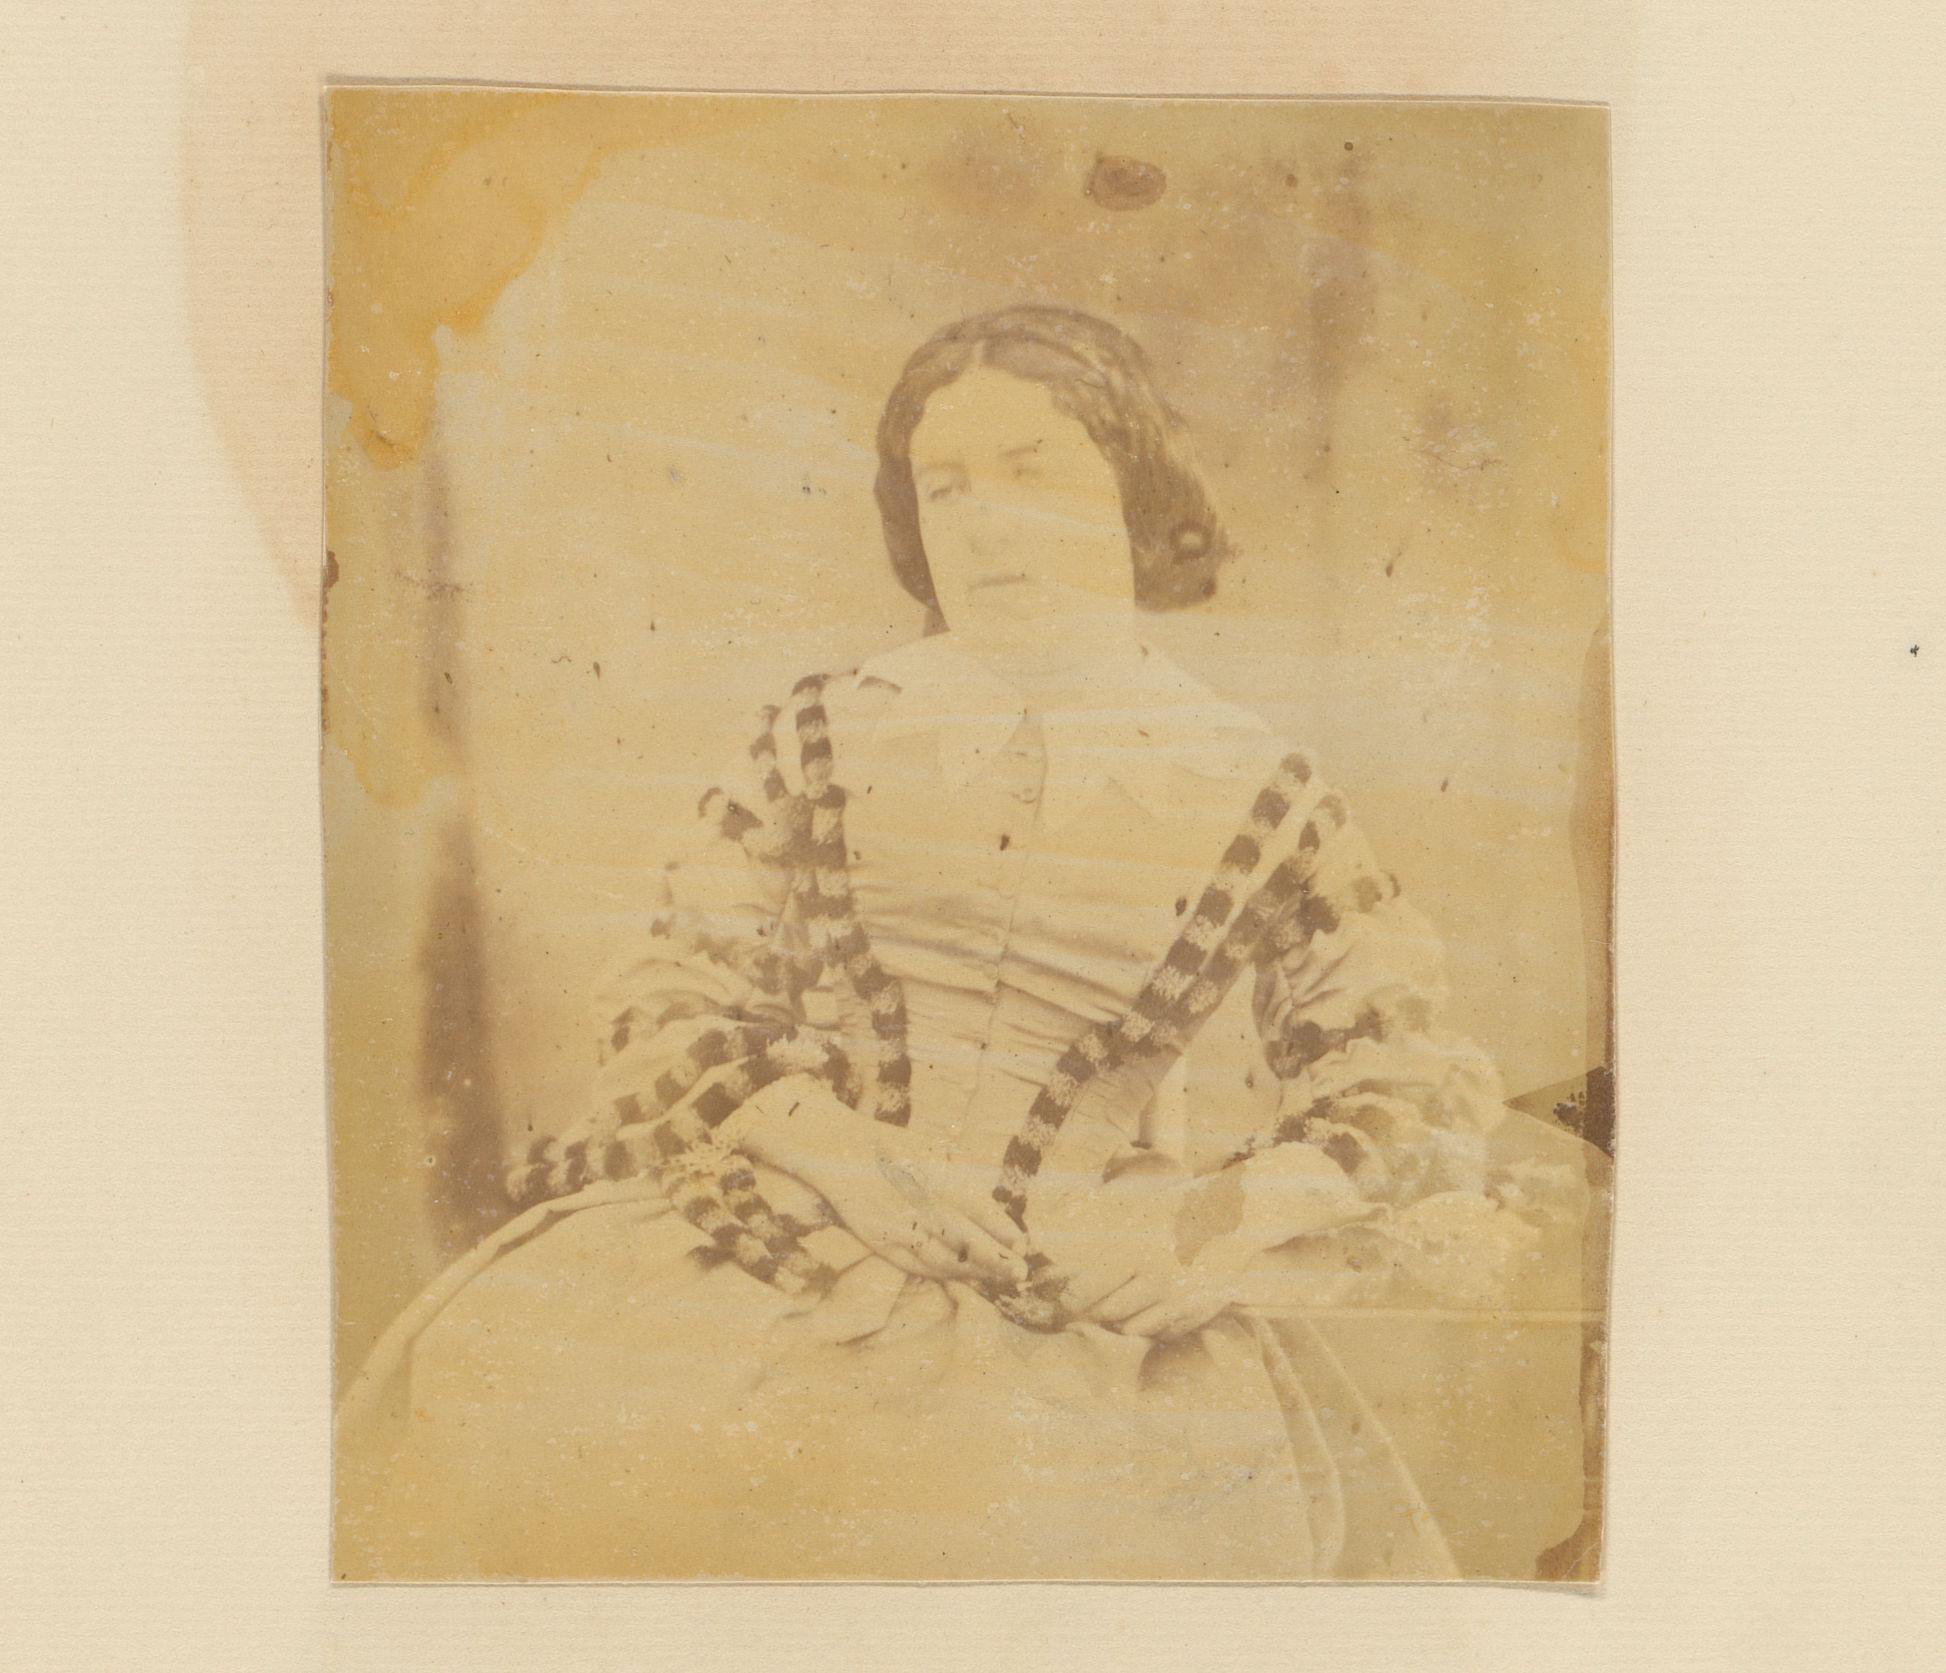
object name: photograph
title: Portret van Charlotte Asser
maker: eduard isaac asser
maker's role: amateurfotograaf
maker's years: 1809-1894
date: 1854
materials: cardboard, paper, photographic support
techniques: salted paper print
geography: amsterdam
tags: brussels, historical persons - bb - woman, netherlands